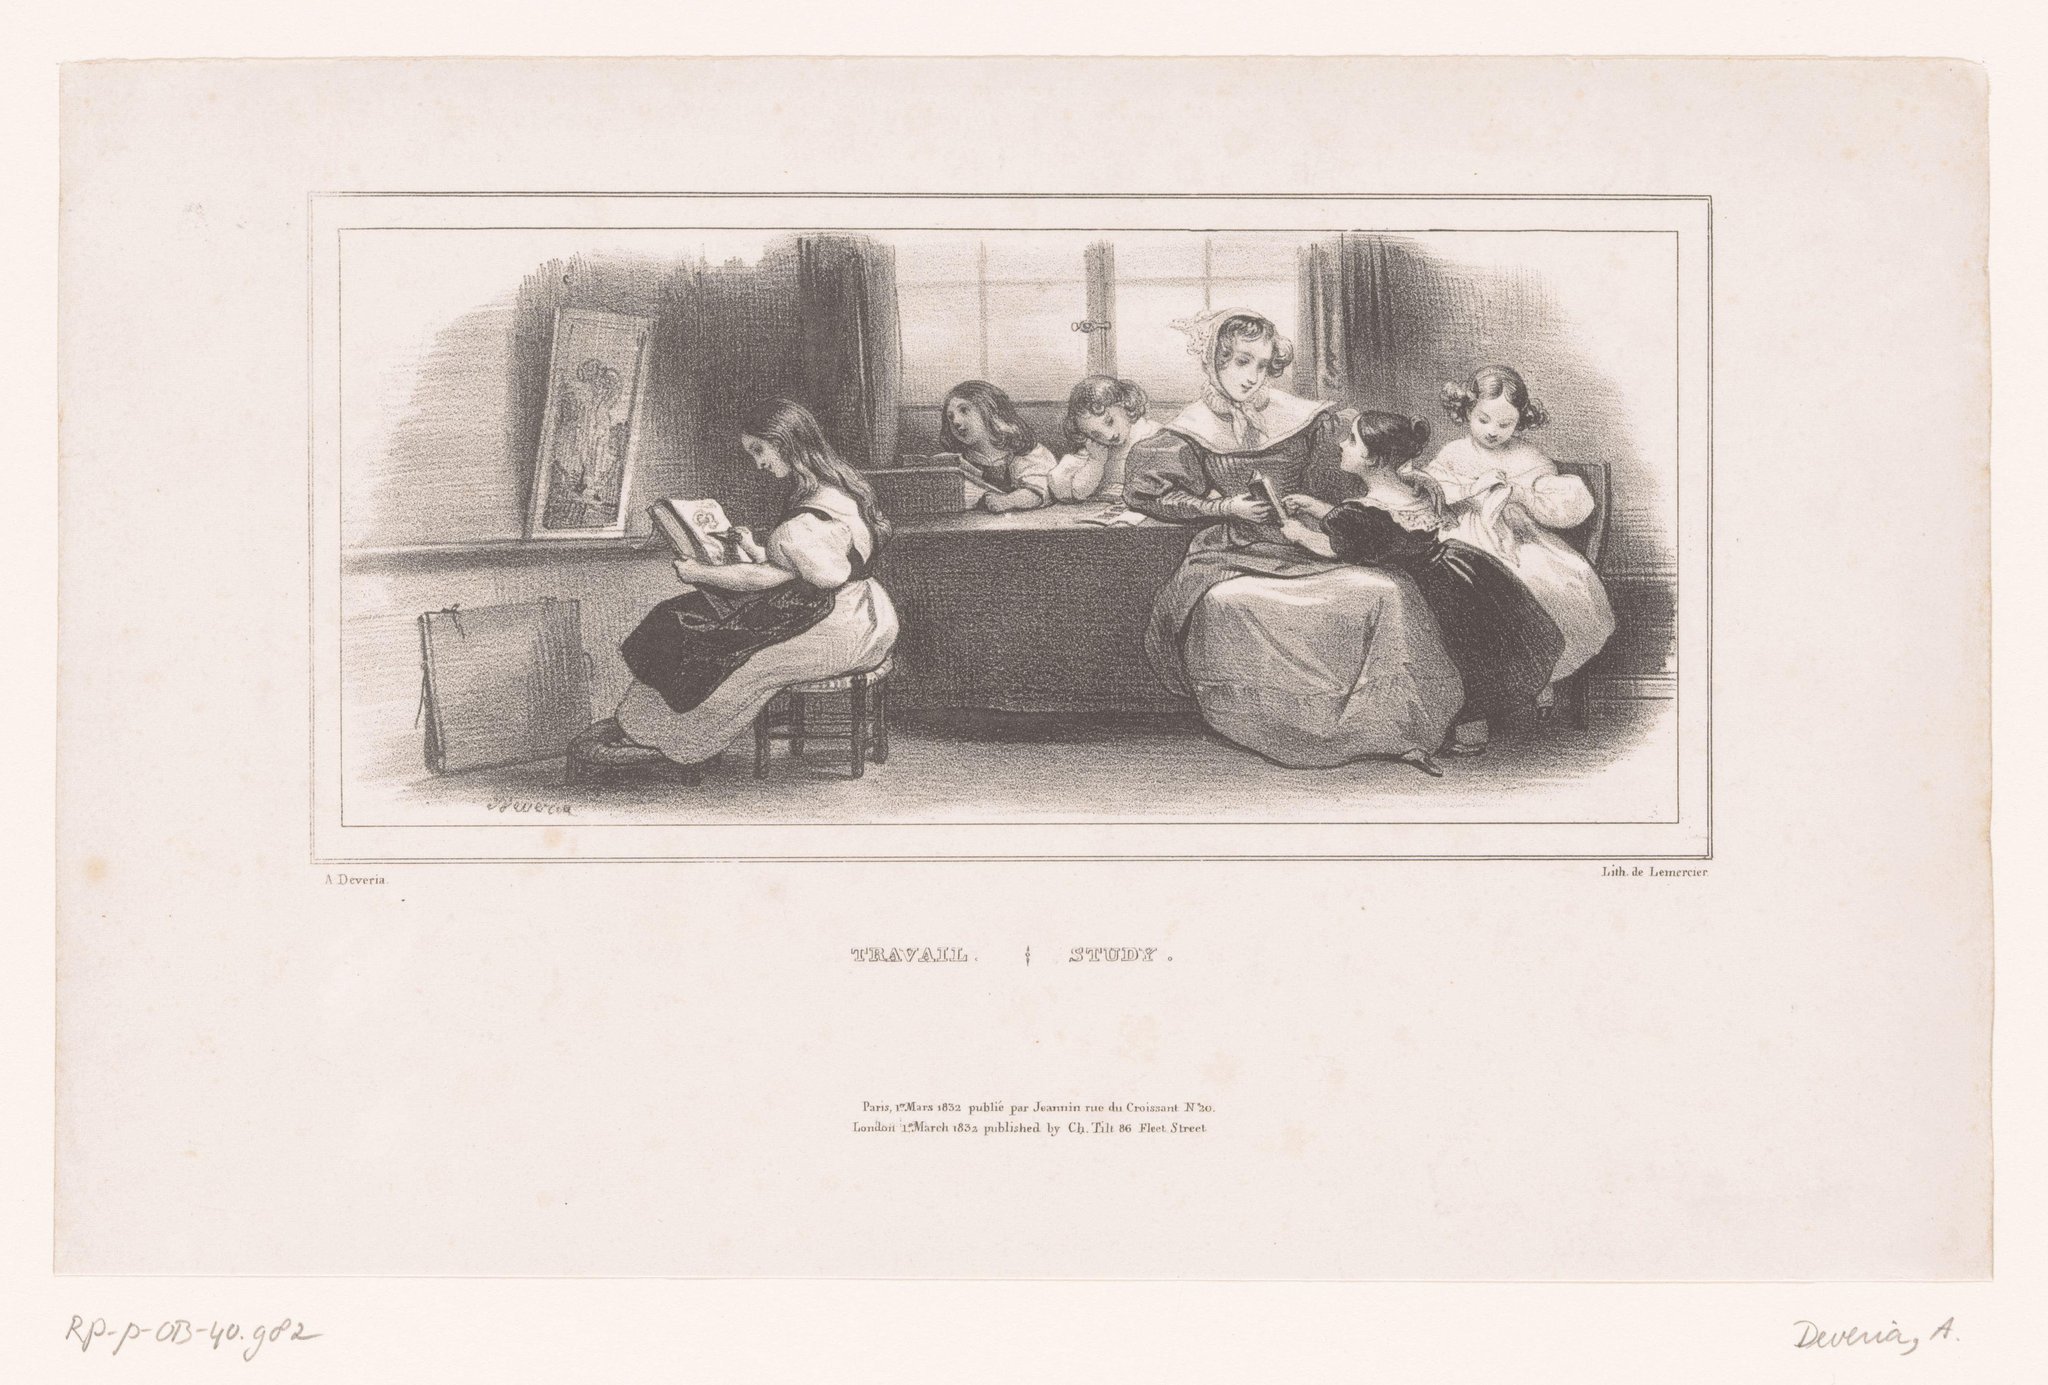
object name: print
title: Diverse schetsen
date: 1832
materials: paper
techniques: lithograph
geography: paris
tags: mother and child(ren), woman and child(ren) (family group) (with number of children), tasks performed by children - aa - girl, child (at home) - aa - girl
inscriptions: check stamp: Lugt 3987, collector's mark: Lugt 2166